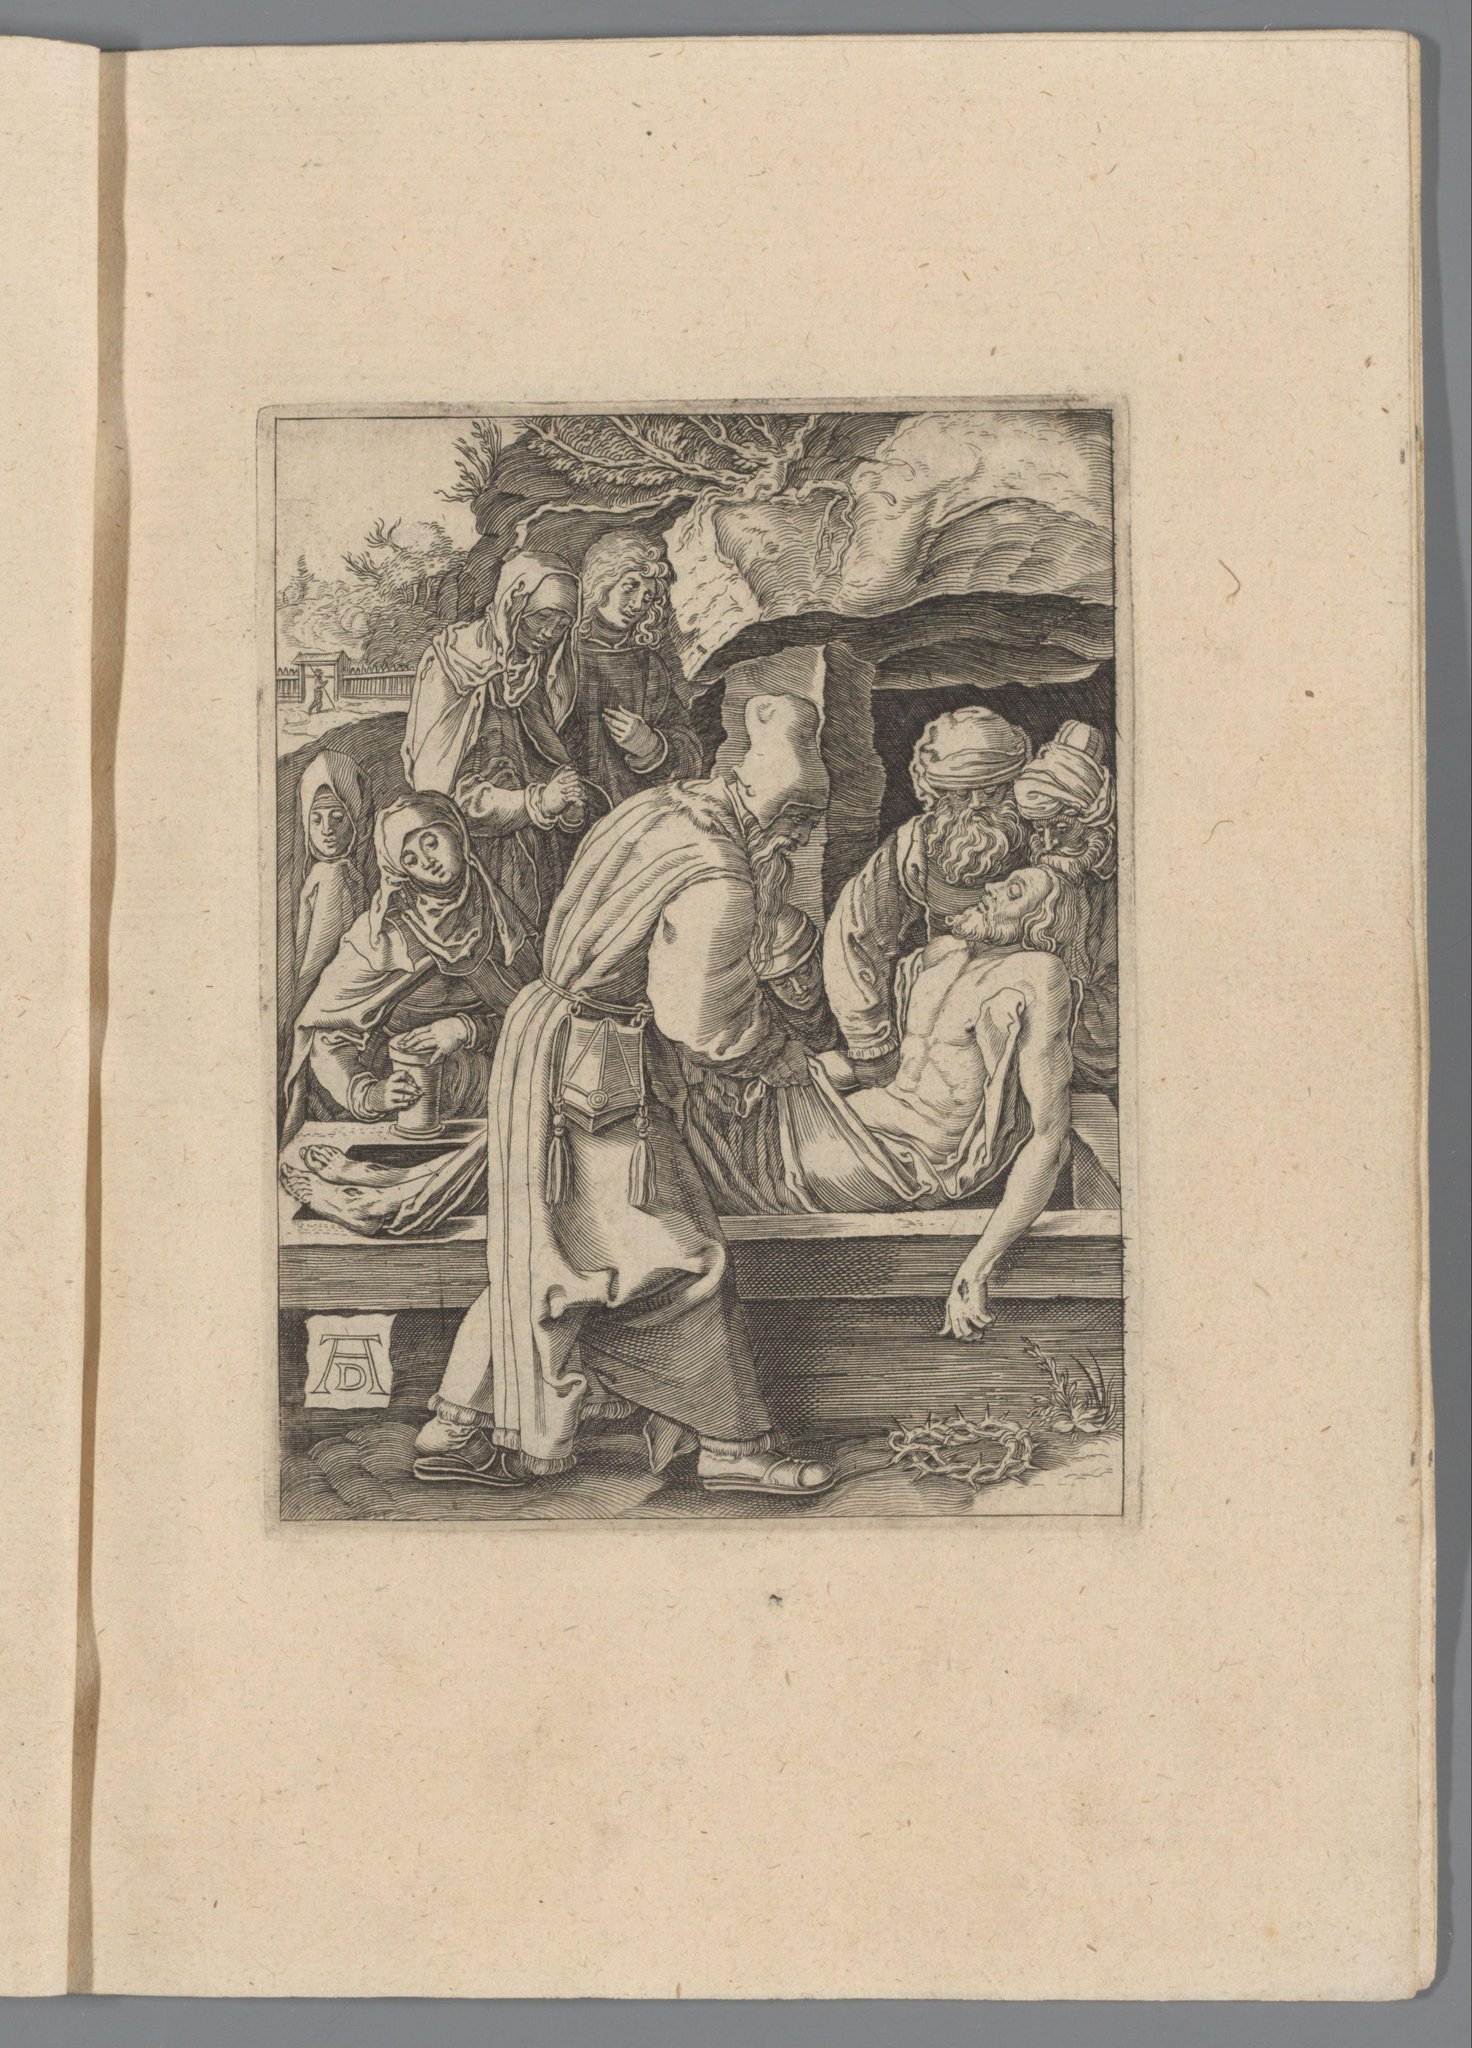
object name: print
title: Passio Christi Ab Alberto Durer Nurenburgensi Effigiata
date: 1610-1620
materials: paper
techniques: engraving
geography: the hague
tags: christ's entombment (possibly by angels)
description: Het lichaam van Christus wordt in een graf gelegd. Prent maakt deel uit van een album.